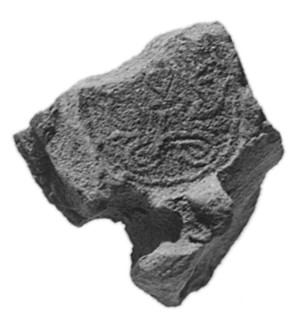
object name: sealing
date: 2030-1640 BCE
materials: clay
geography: egypt